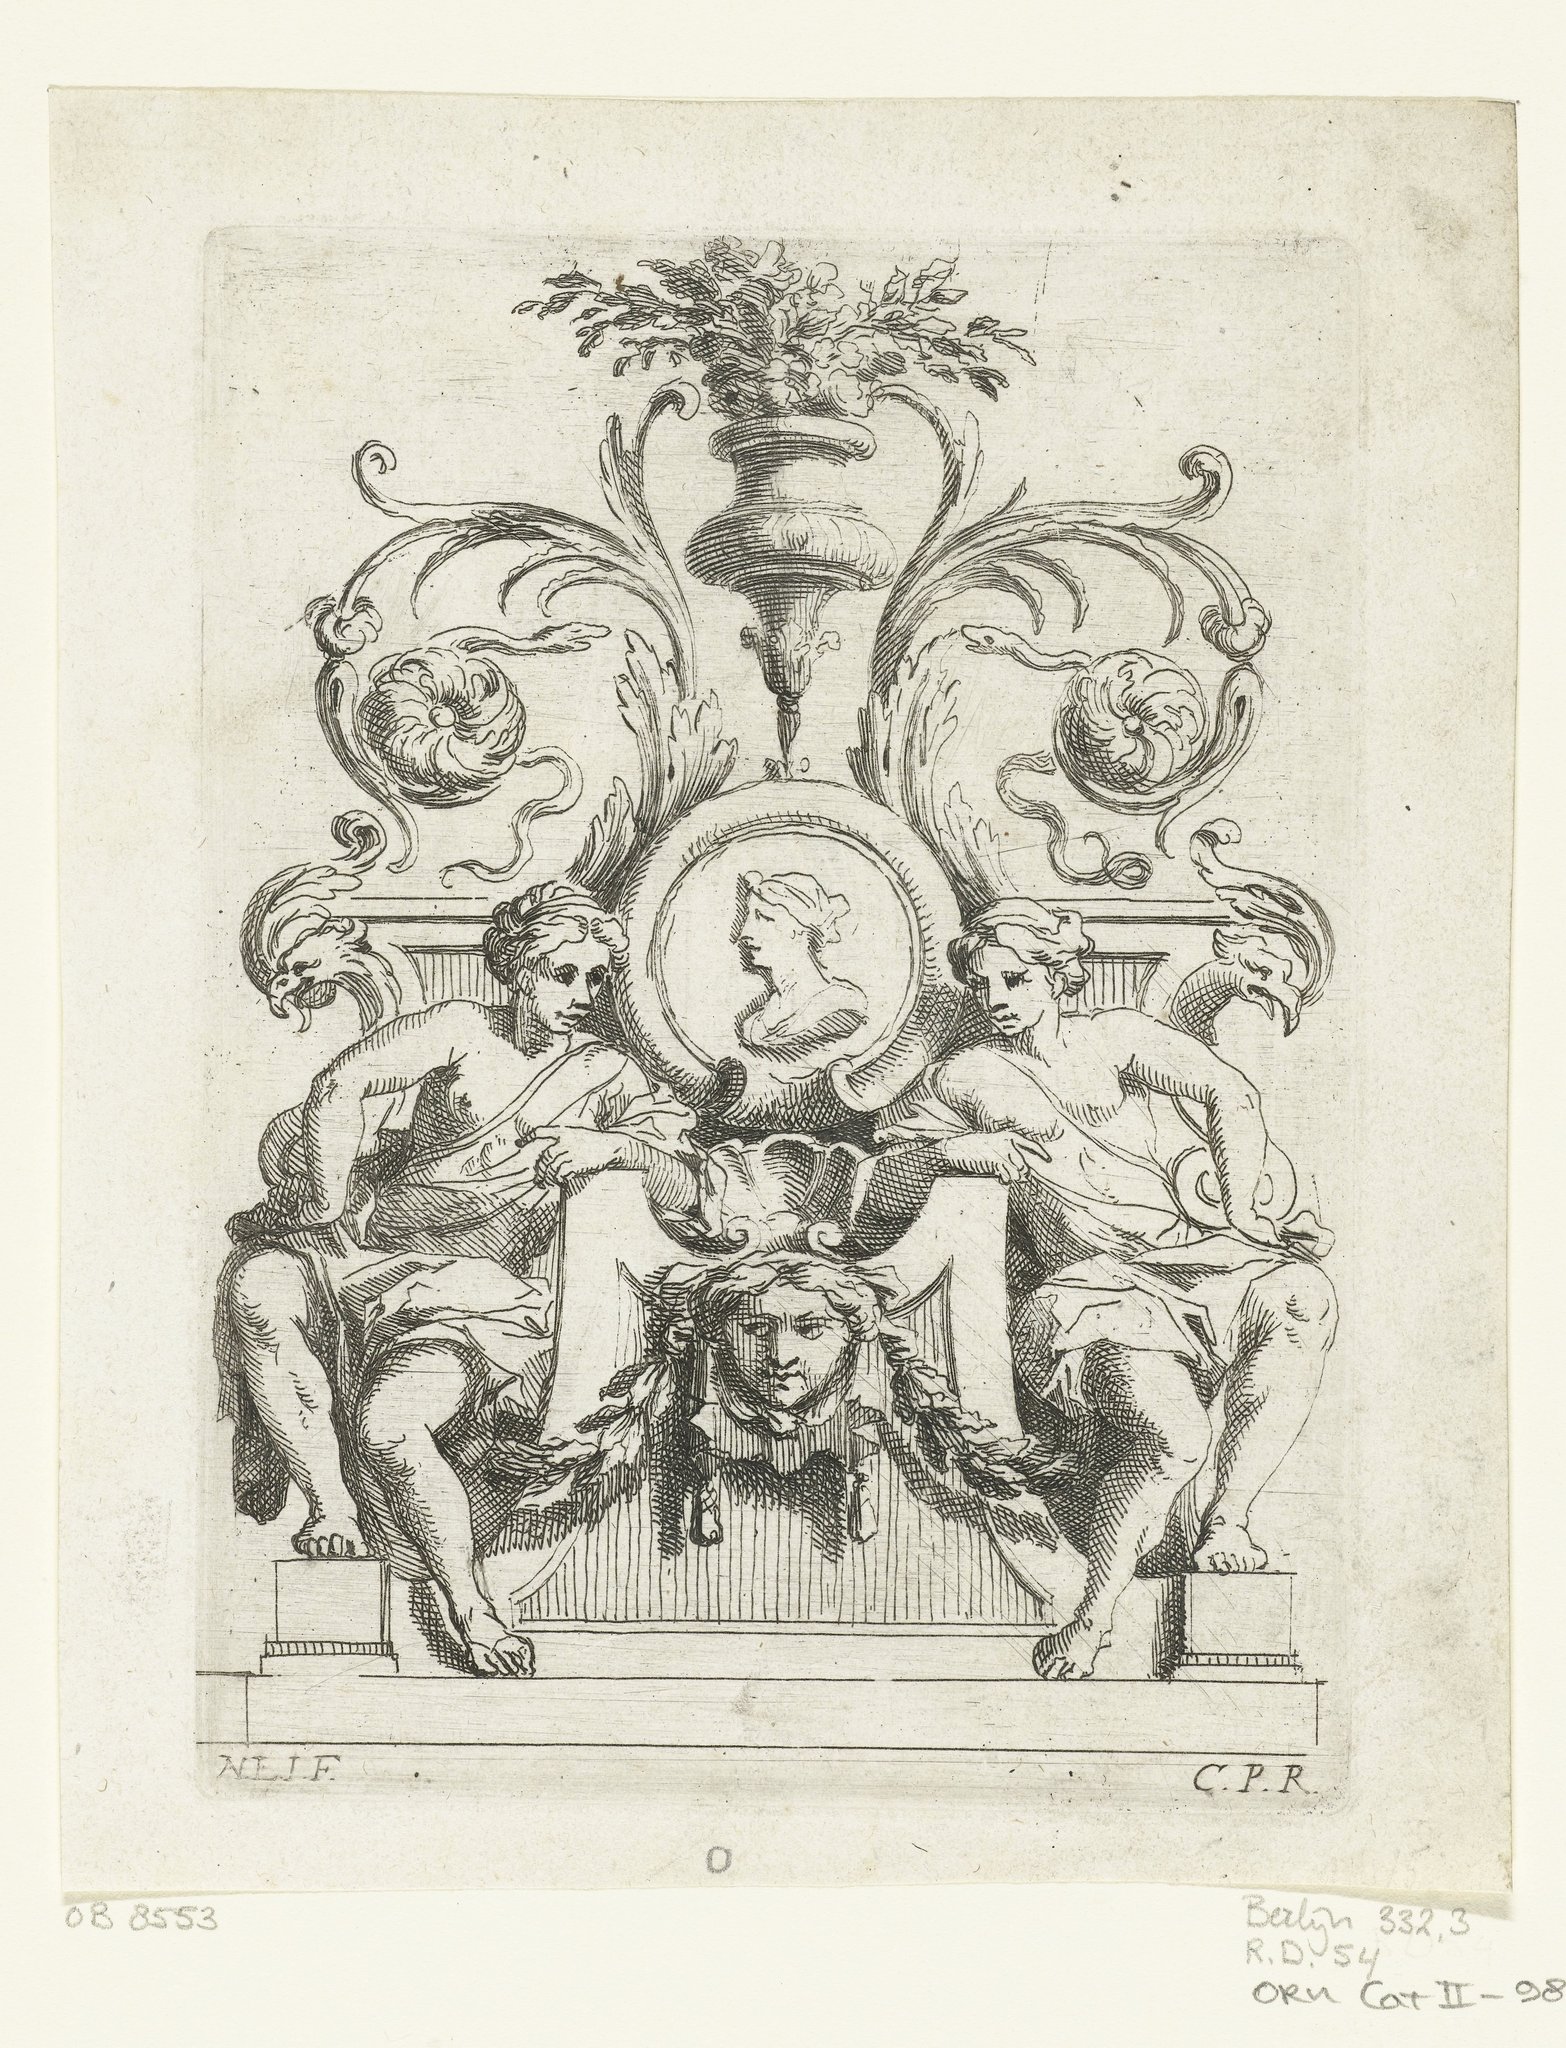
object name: ornament print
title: Twee vrouwen met portretmedaillon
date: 1660-1670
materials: paper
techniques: etching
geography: france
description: De vrouwen zitten op een voetstuk. Blad 9 uit serie van 12.